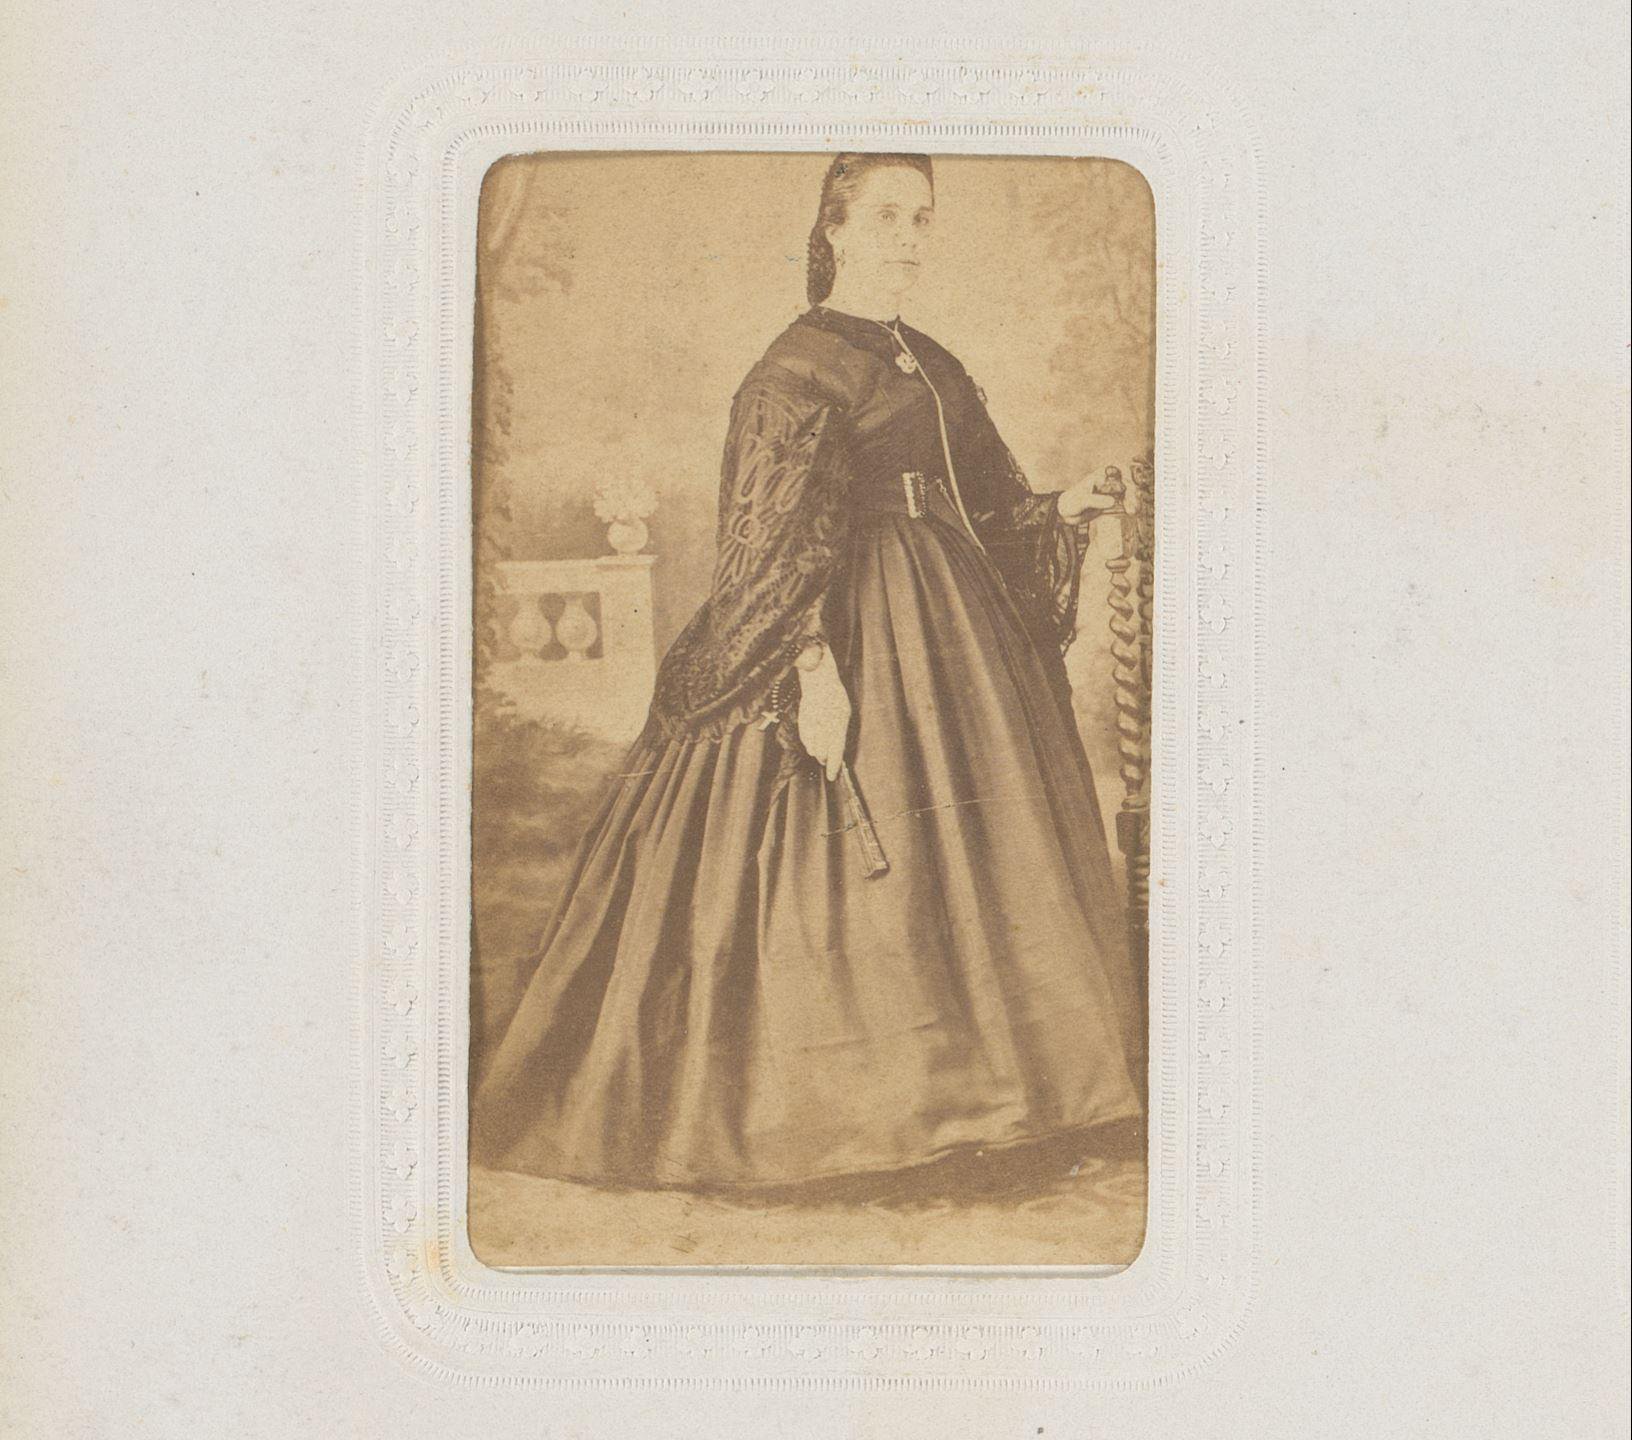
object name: photograph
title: Portret van een vrouw met waaier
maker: josé maria blanco aguilar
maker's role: fotograaf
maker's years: 1823-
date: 1860-1870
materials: cardboard, photographic support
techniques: albumen print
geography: cádiz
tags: historical persons - bb - woman, fan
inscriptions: inscription: ‘Jose Ma. Blanco/ Fotografo/ Calle del Vestuario 20/ Cádiz’